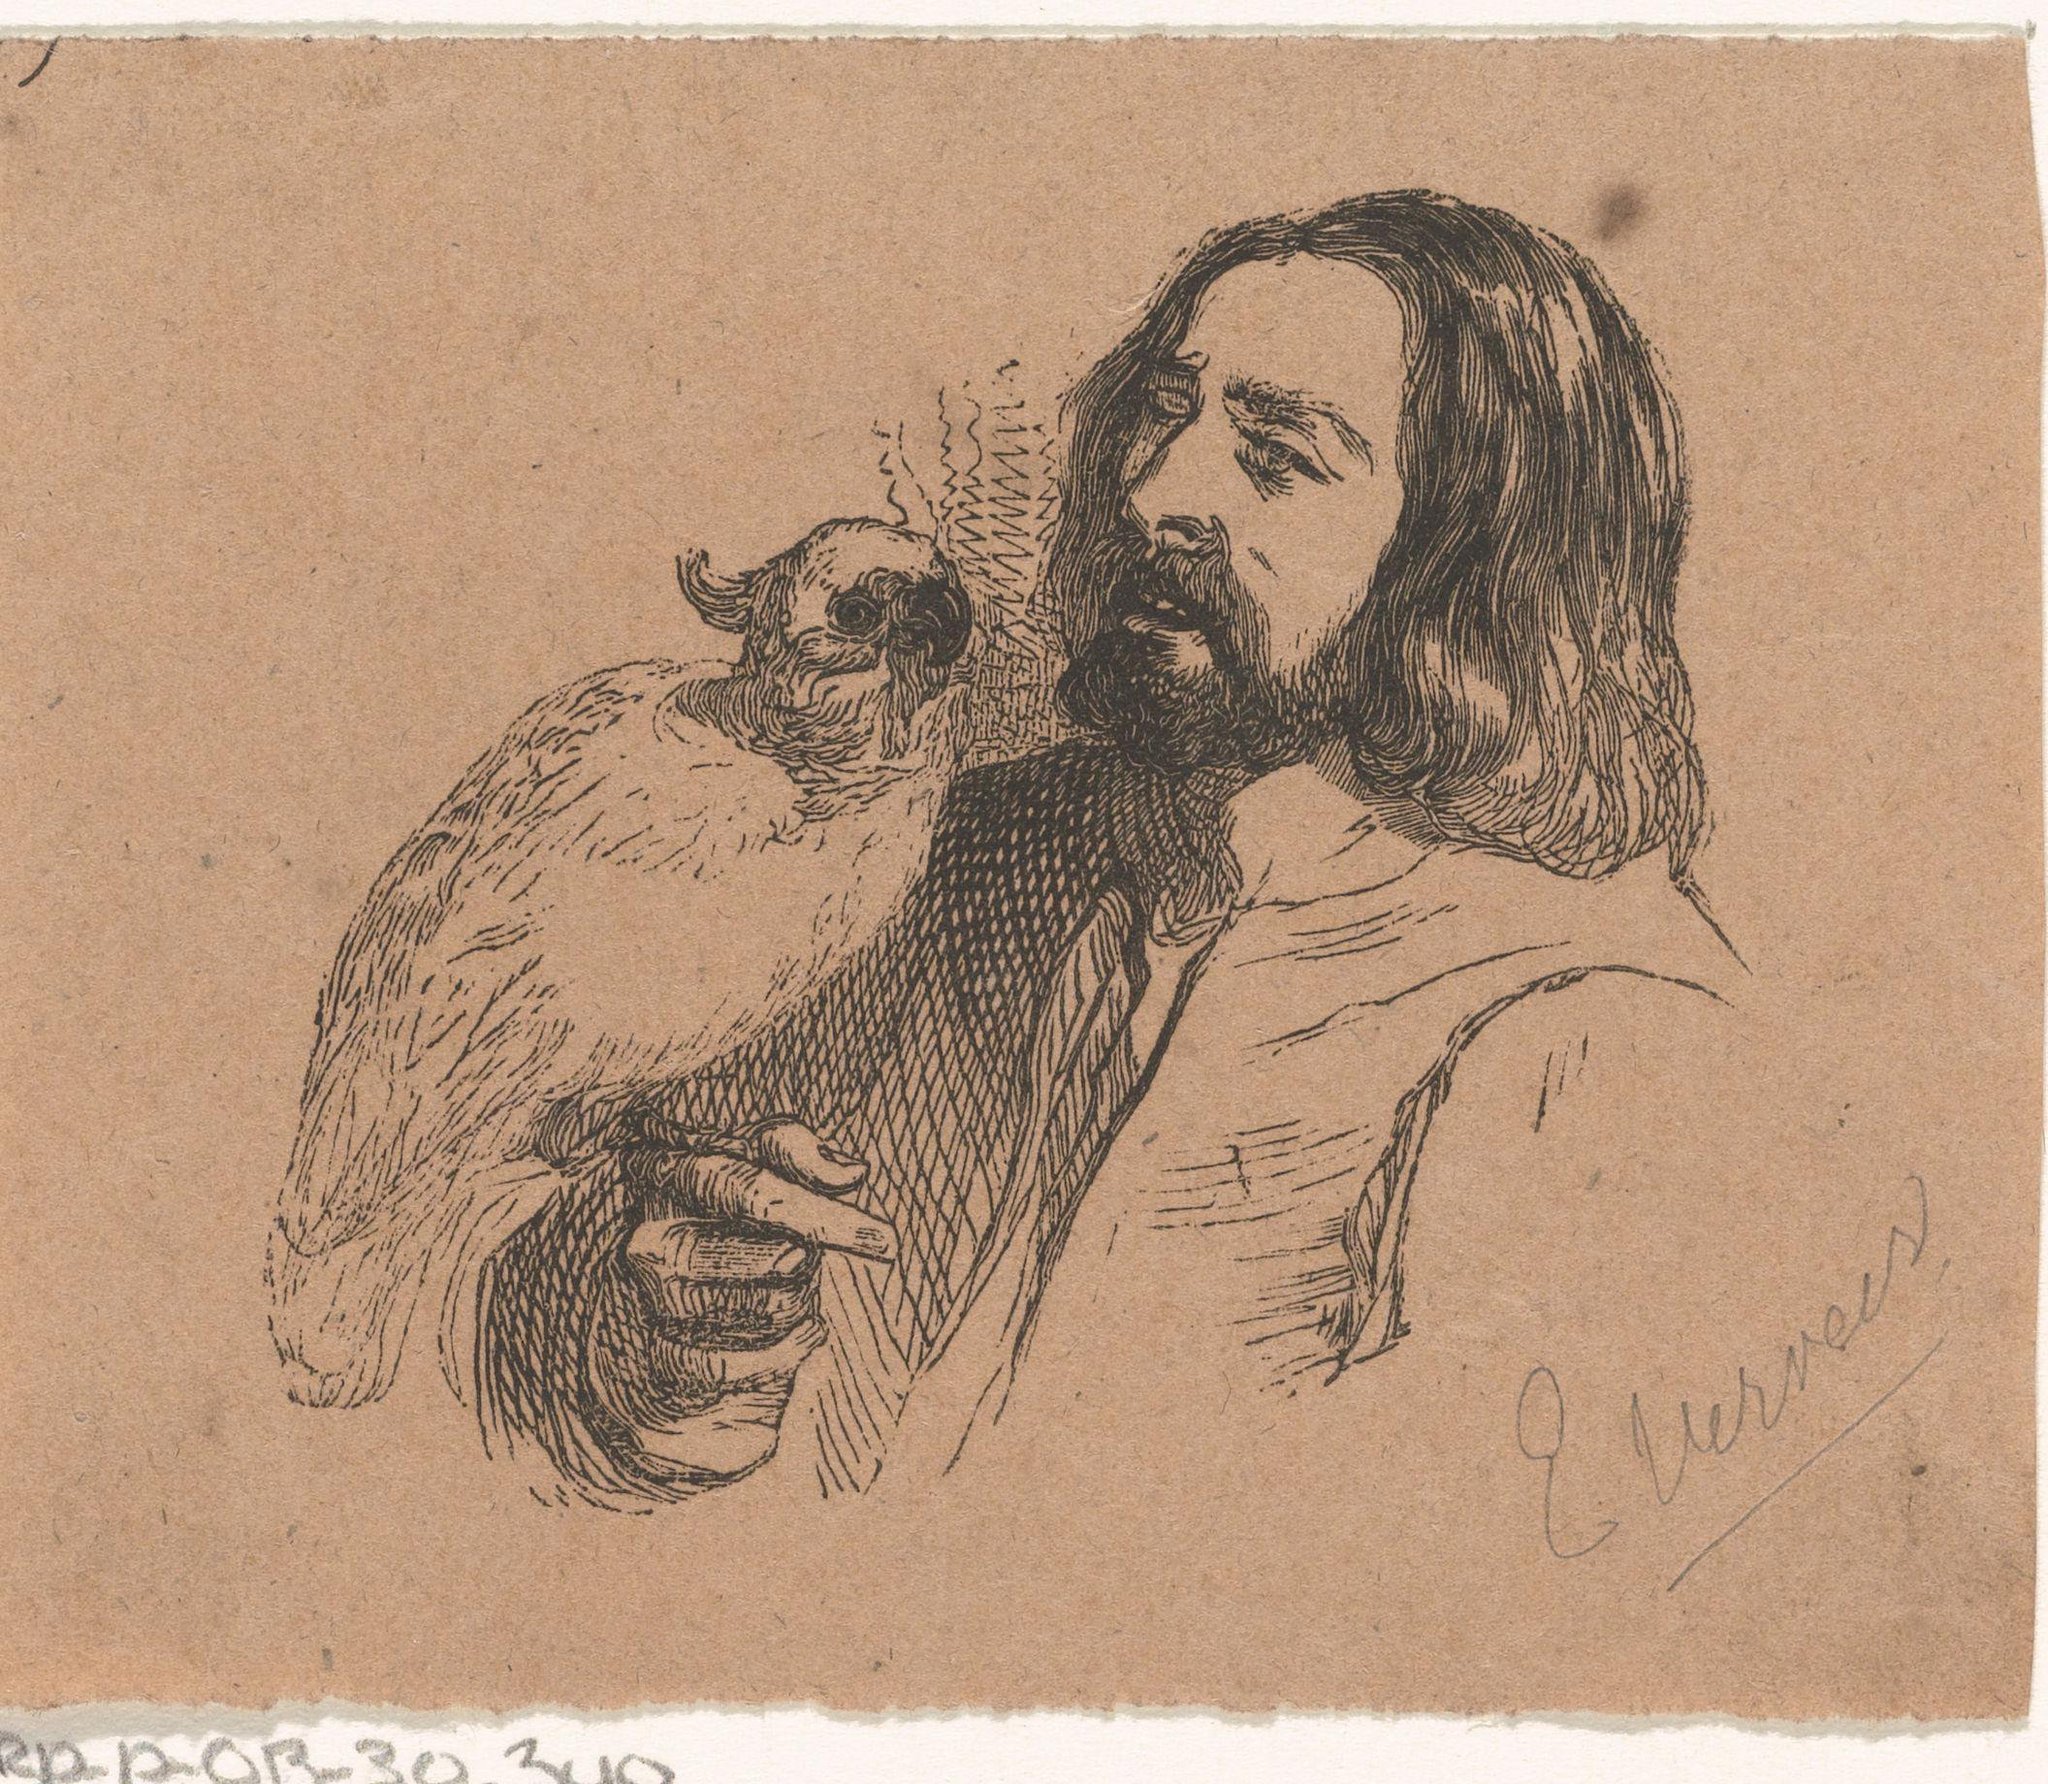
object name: print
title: Man met een papegaai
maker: elchanon verveer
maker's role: draughtsman, print maker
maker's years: 1826-1900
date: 1836-1900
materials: paper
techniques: engraving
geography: the hague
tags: ornamental birds: parrot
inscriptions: collector's mark: Lugt 2228